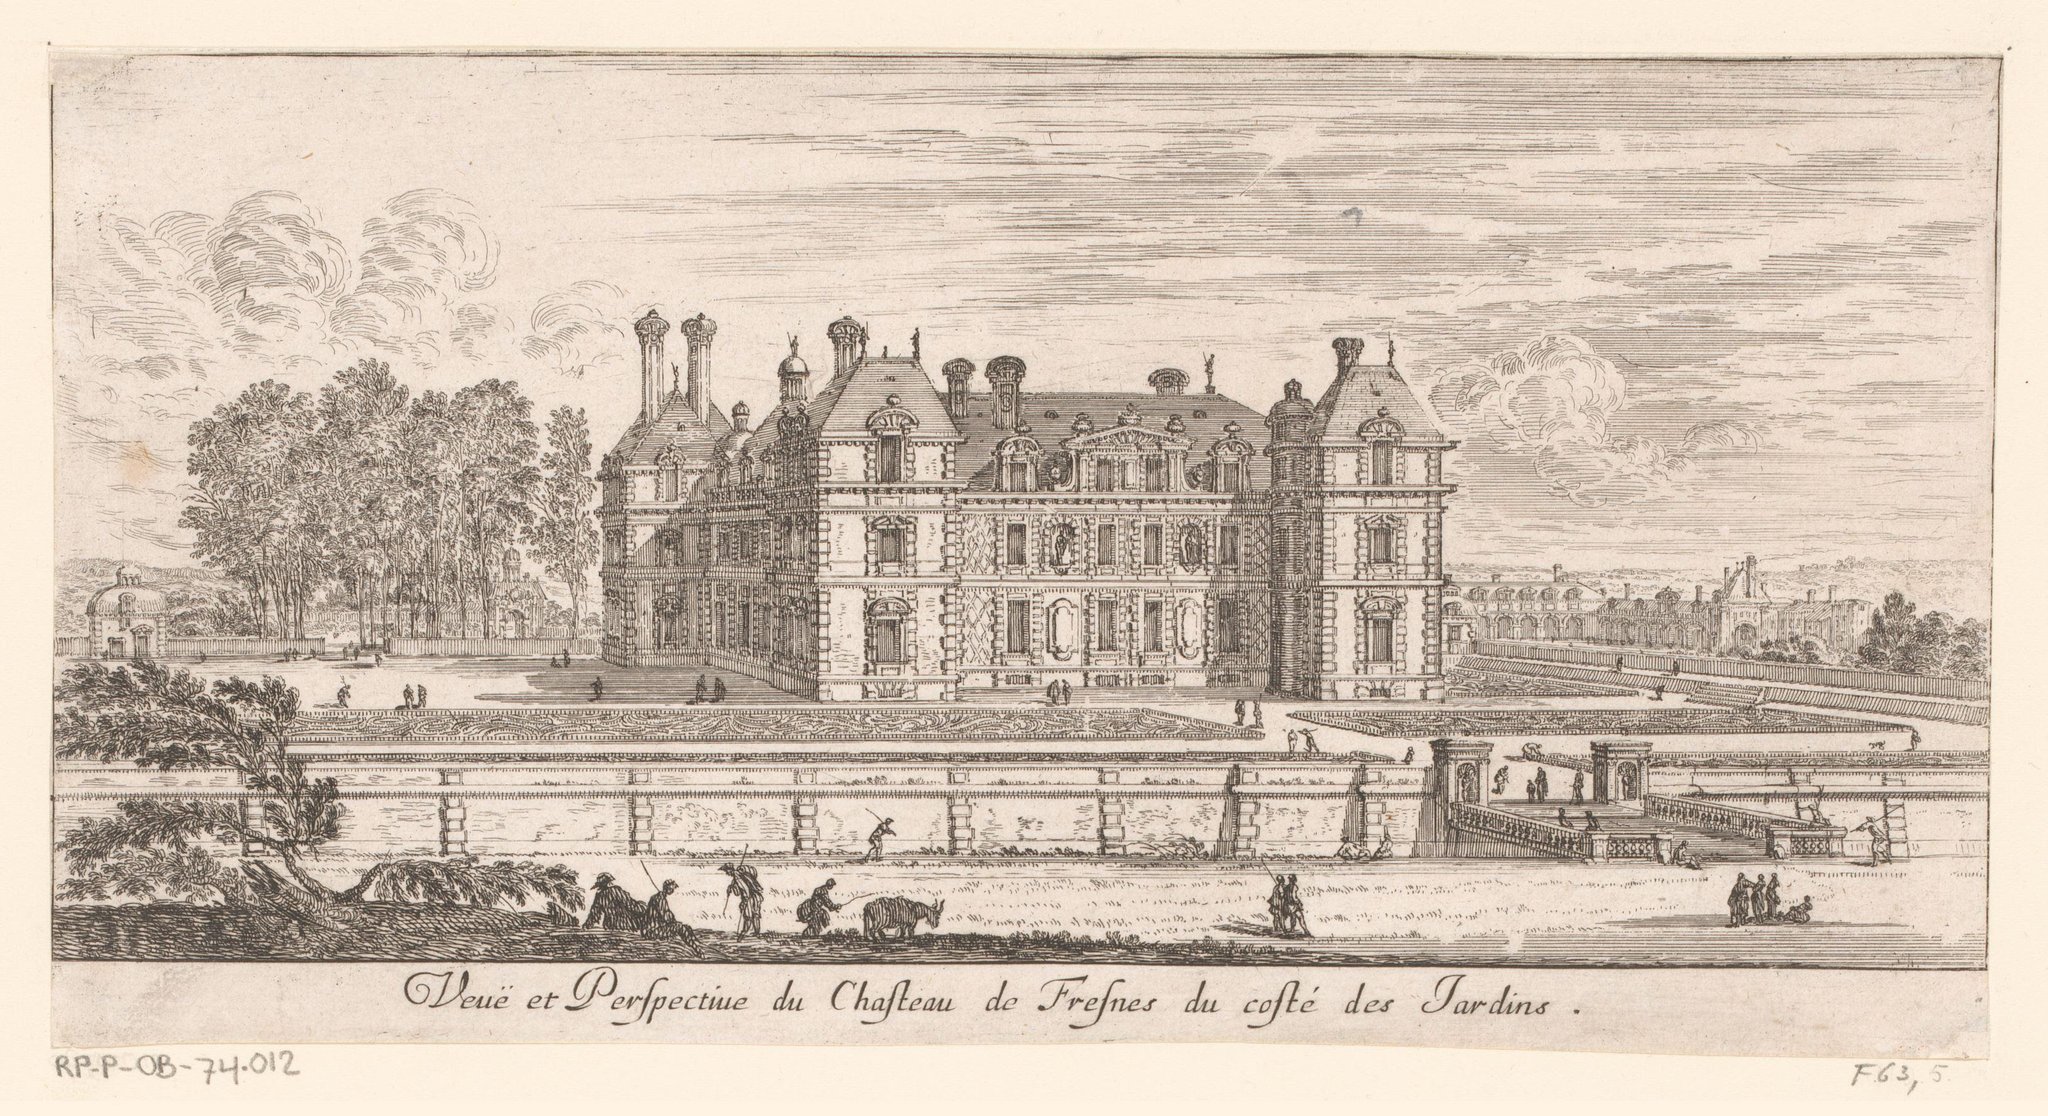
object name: print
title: Gezicht op kasteel Fresne aan de kant van de tuinen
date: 1654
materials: paper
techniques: engraving, etching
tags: french or architectonic garden; formal garden, landscape with tower or castle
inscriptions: collector's mark: Lugt 240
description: Prent maakt deel uit van een ongenummerde serie van 21 prenten.